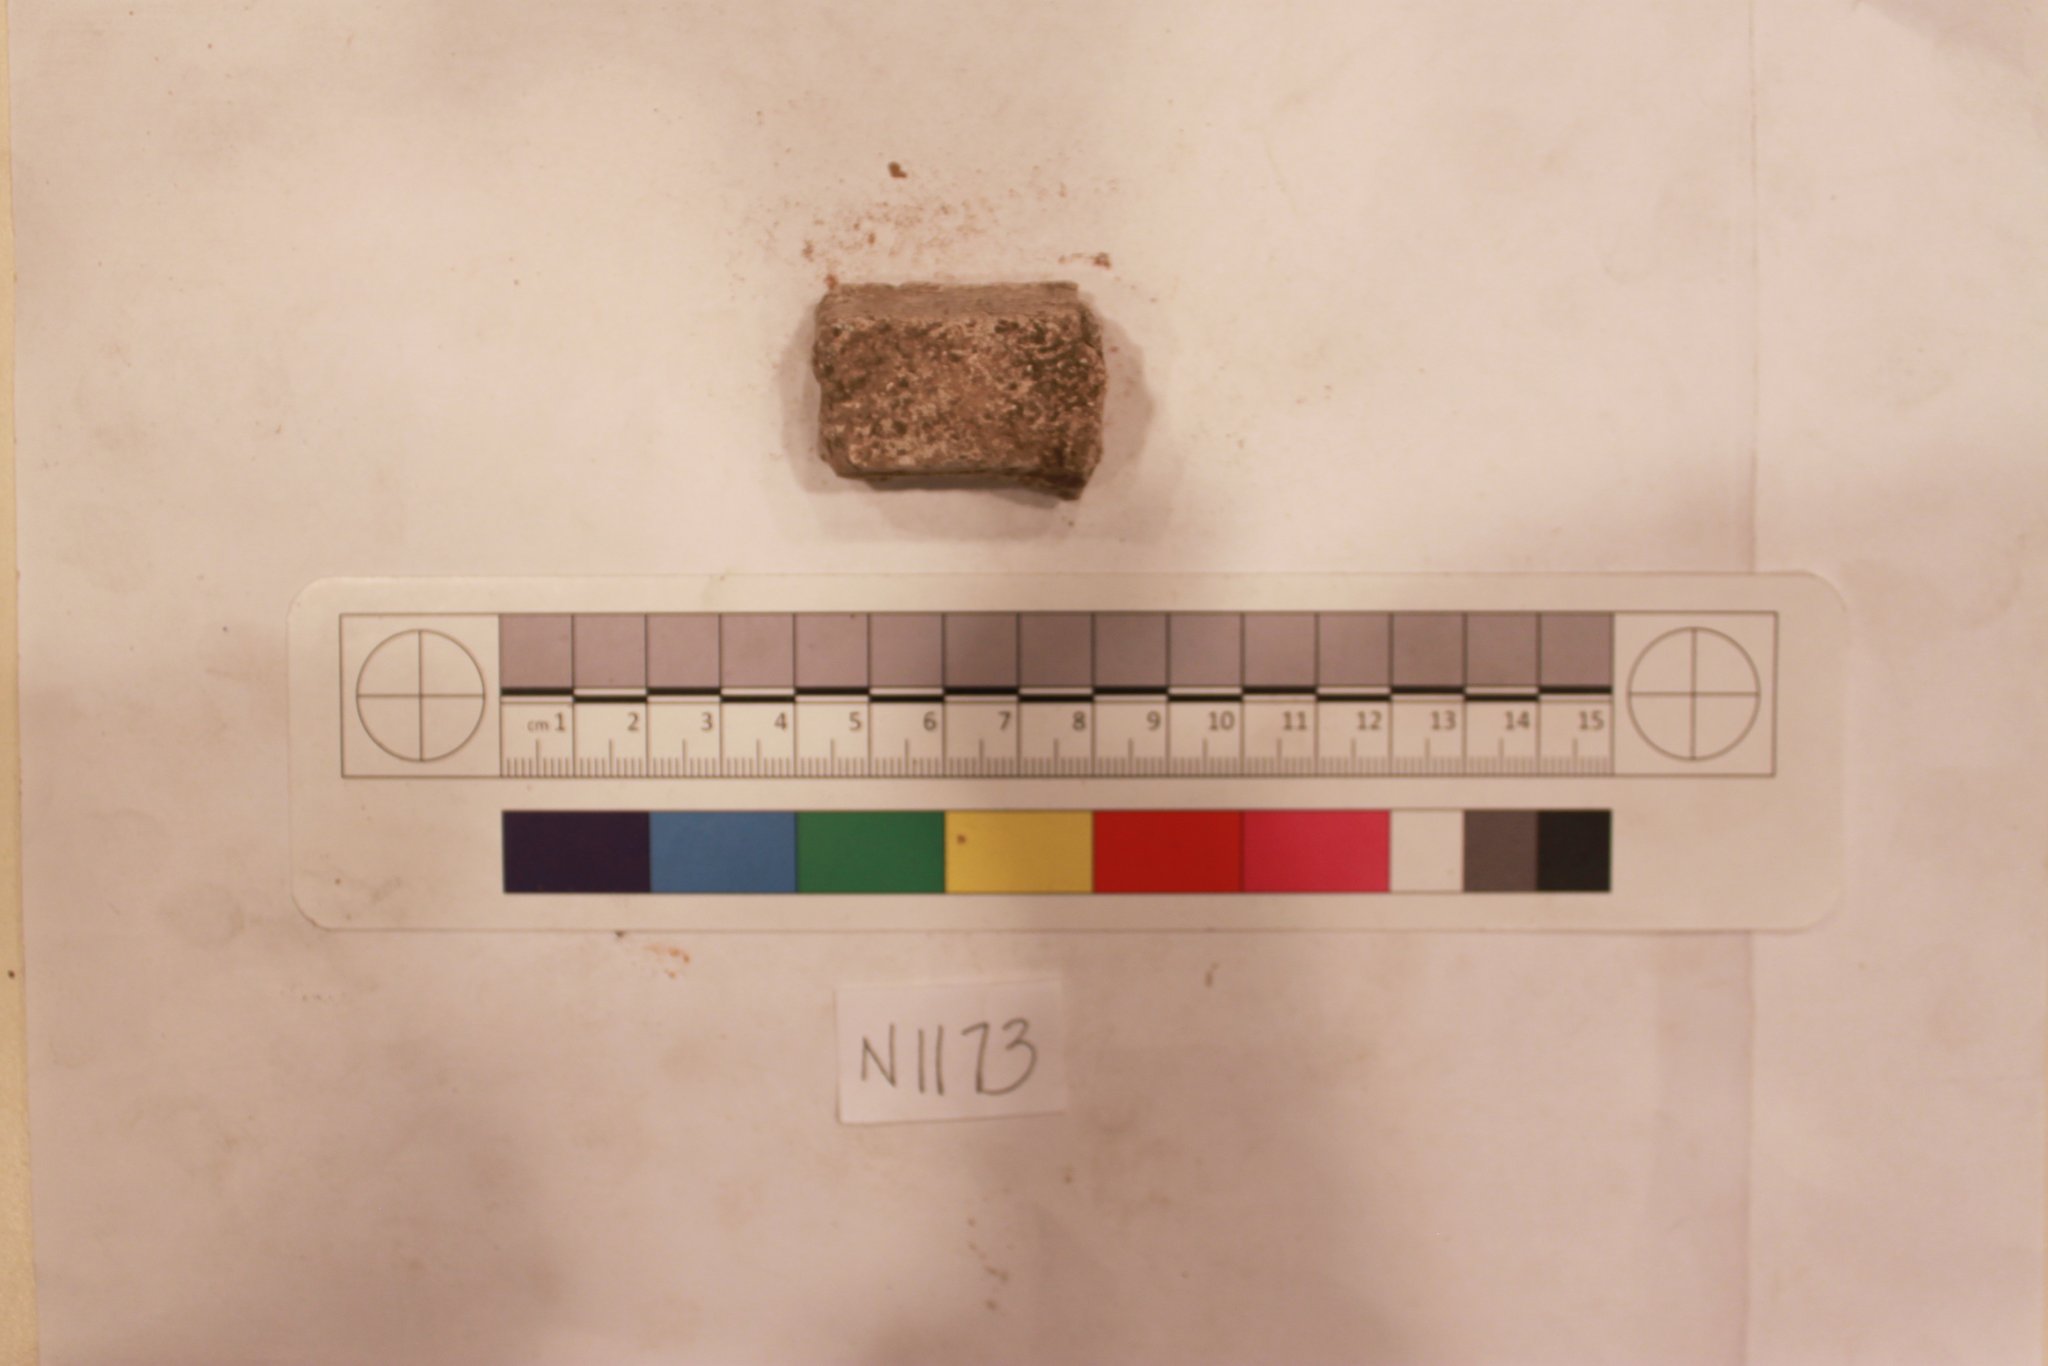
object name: fragment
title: Stucco Fragment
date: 701-1200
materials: plaster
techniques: carving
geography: iran